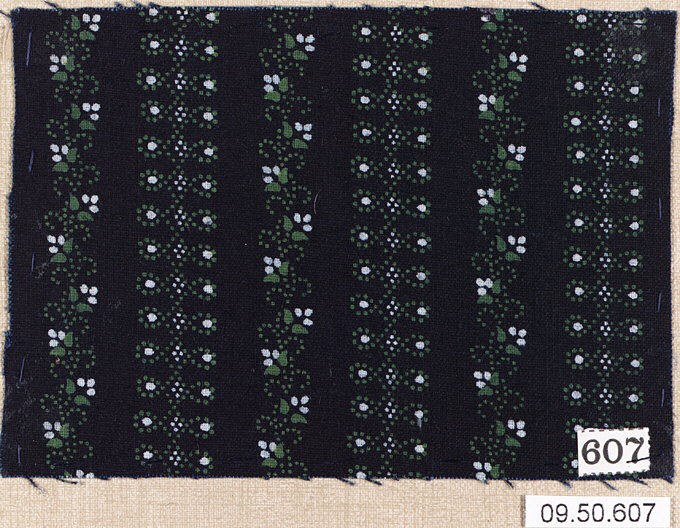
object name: piece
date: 1801-1900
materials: cotton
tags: flowers,leaves